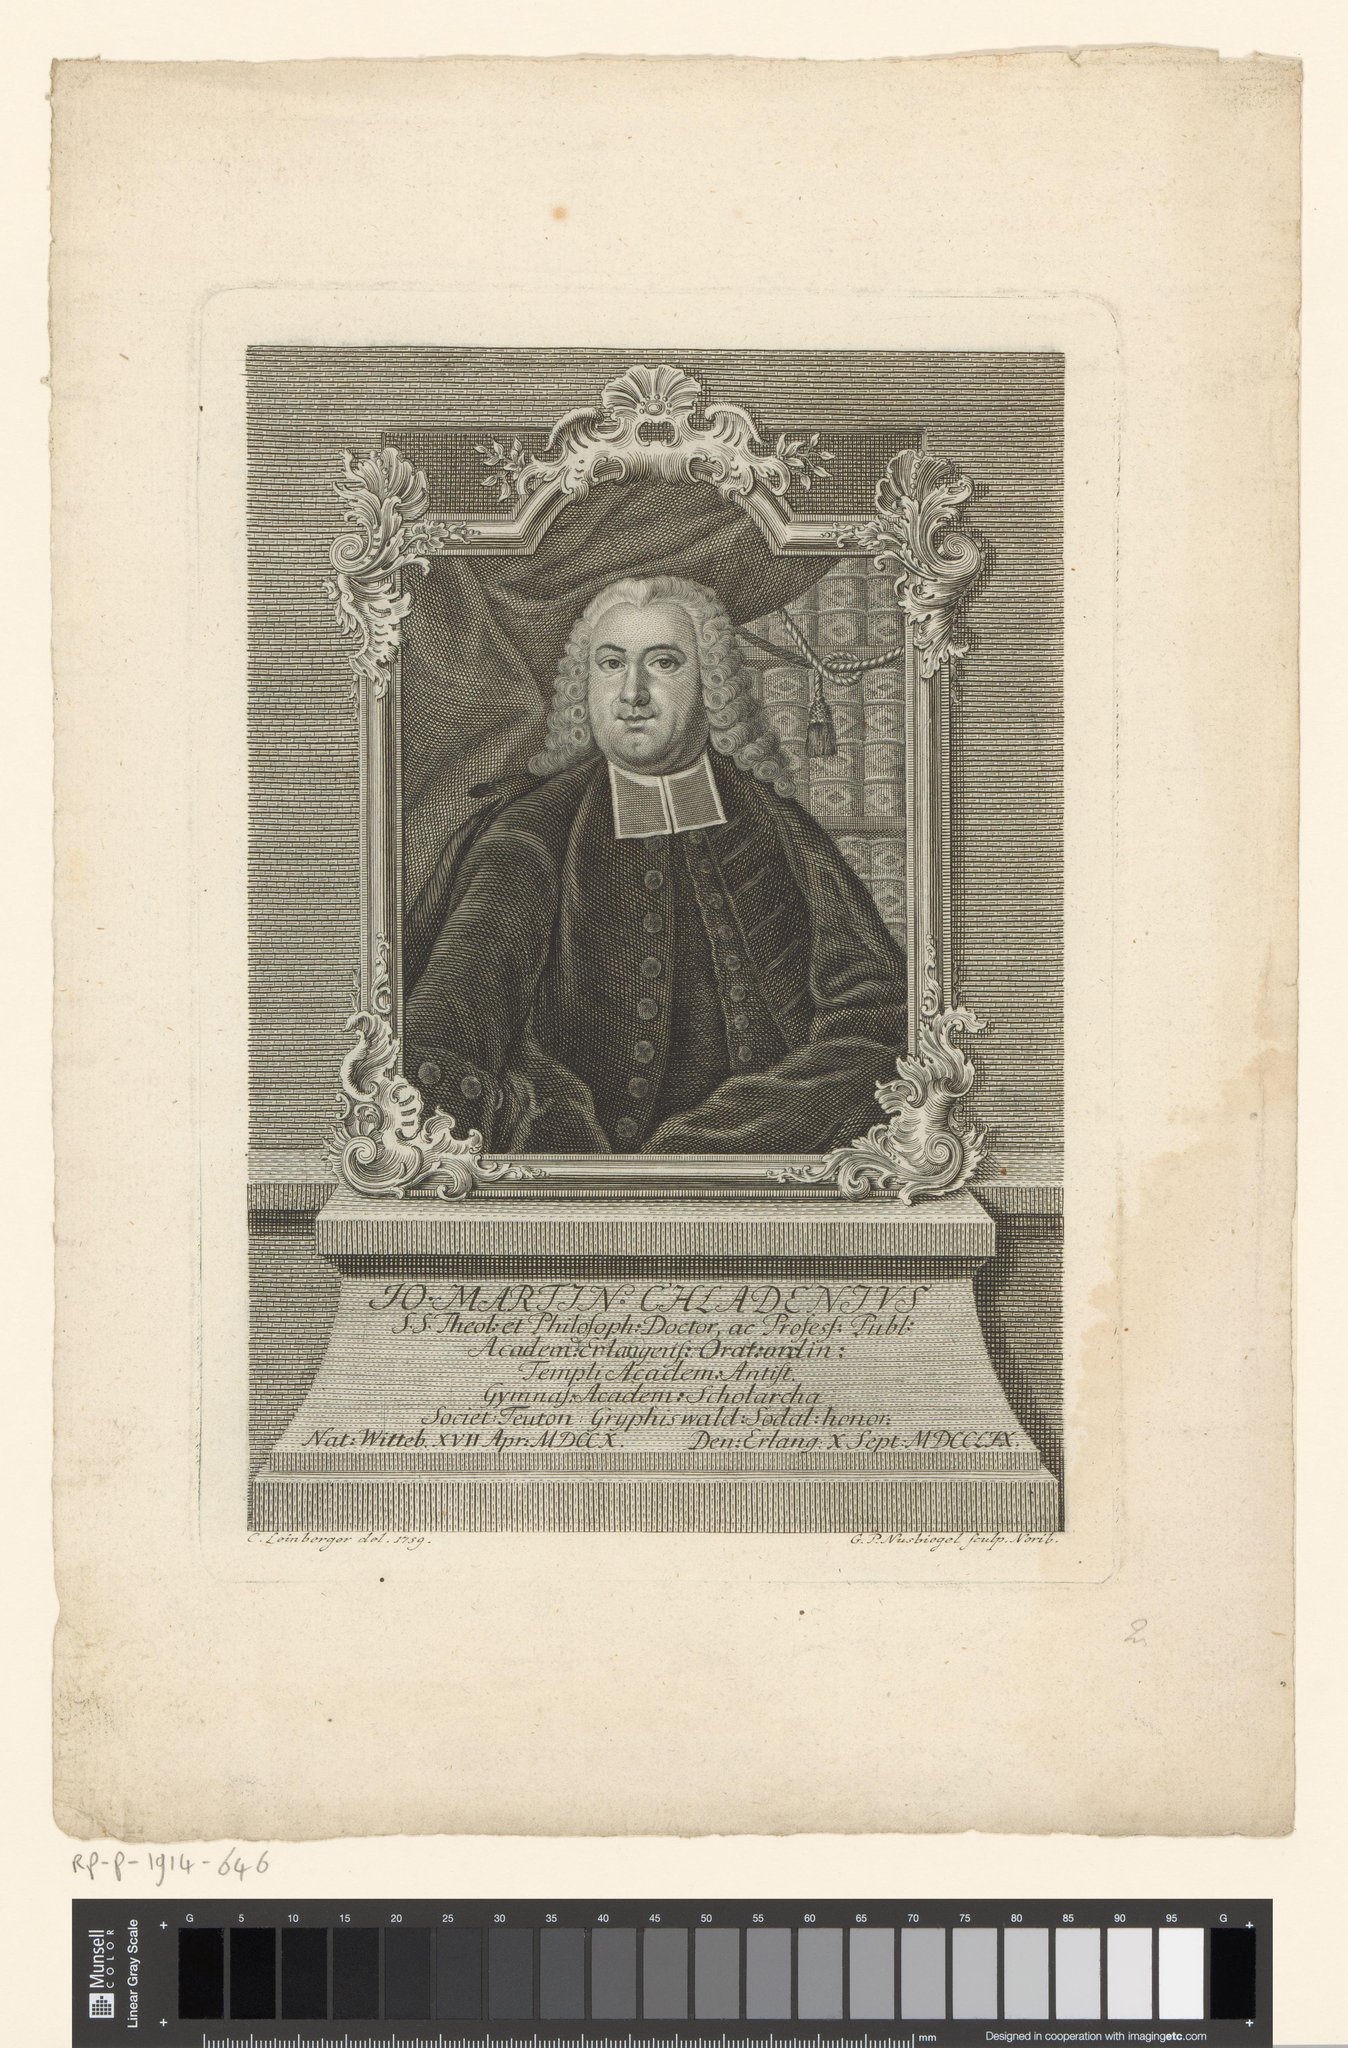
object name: print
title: Portret van Johann Martin Chladni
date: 1759-1786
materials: paper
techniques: engraving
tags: bookshelves, historical persons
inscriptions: collector's mark: Lugt 2228